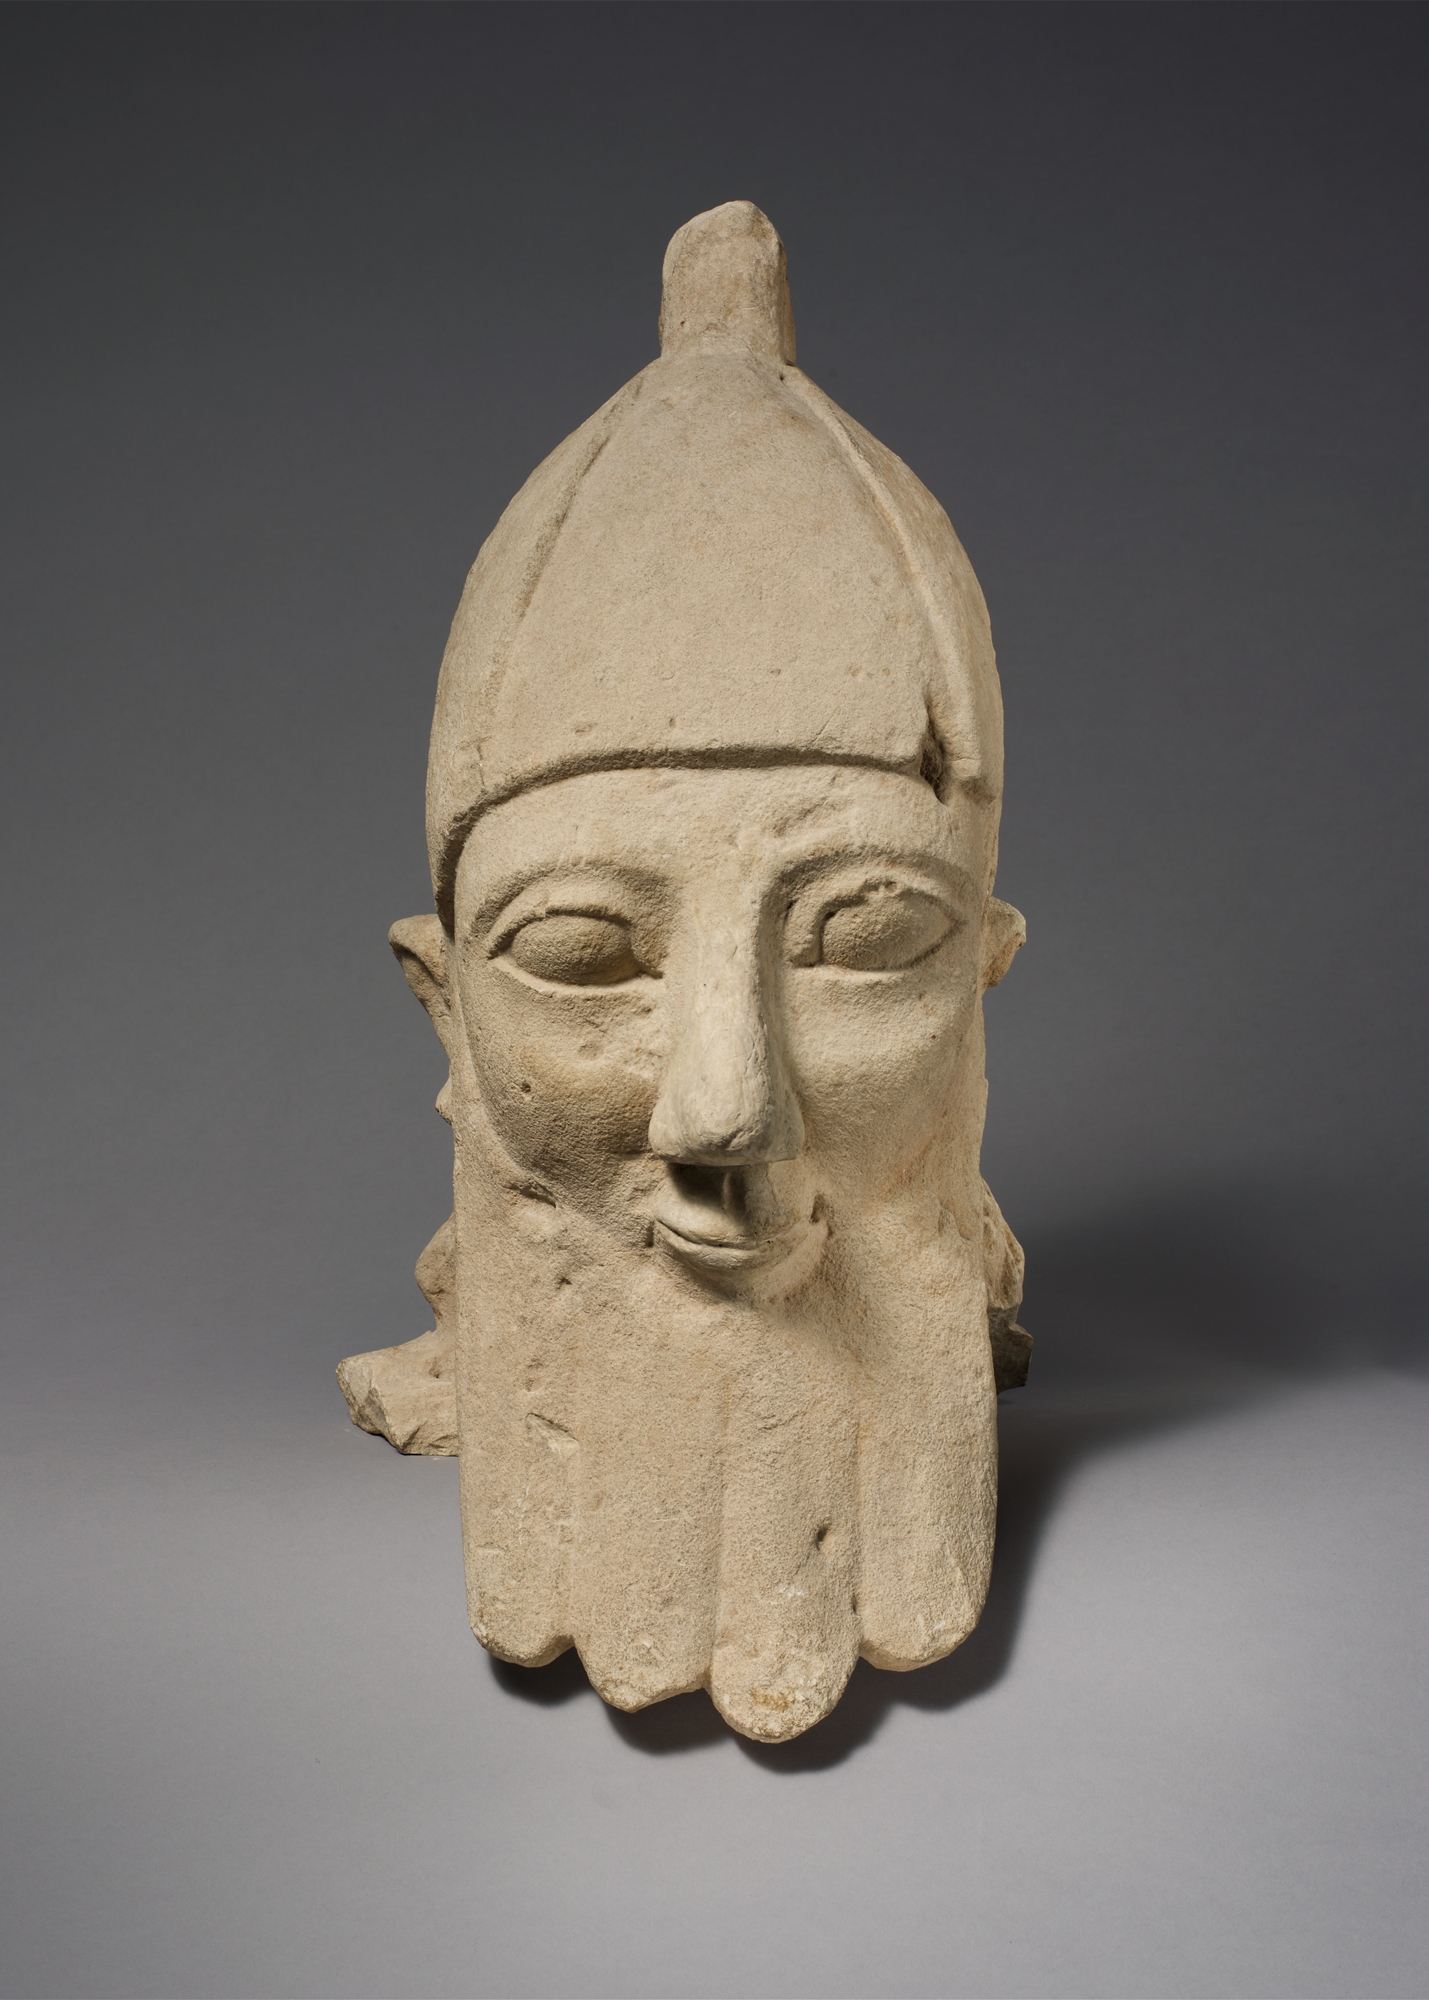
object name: head of a warrior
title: Over-lifesize bearded head wearing a conical helmet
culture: cypriot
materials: limestone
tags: helmets,heads,men